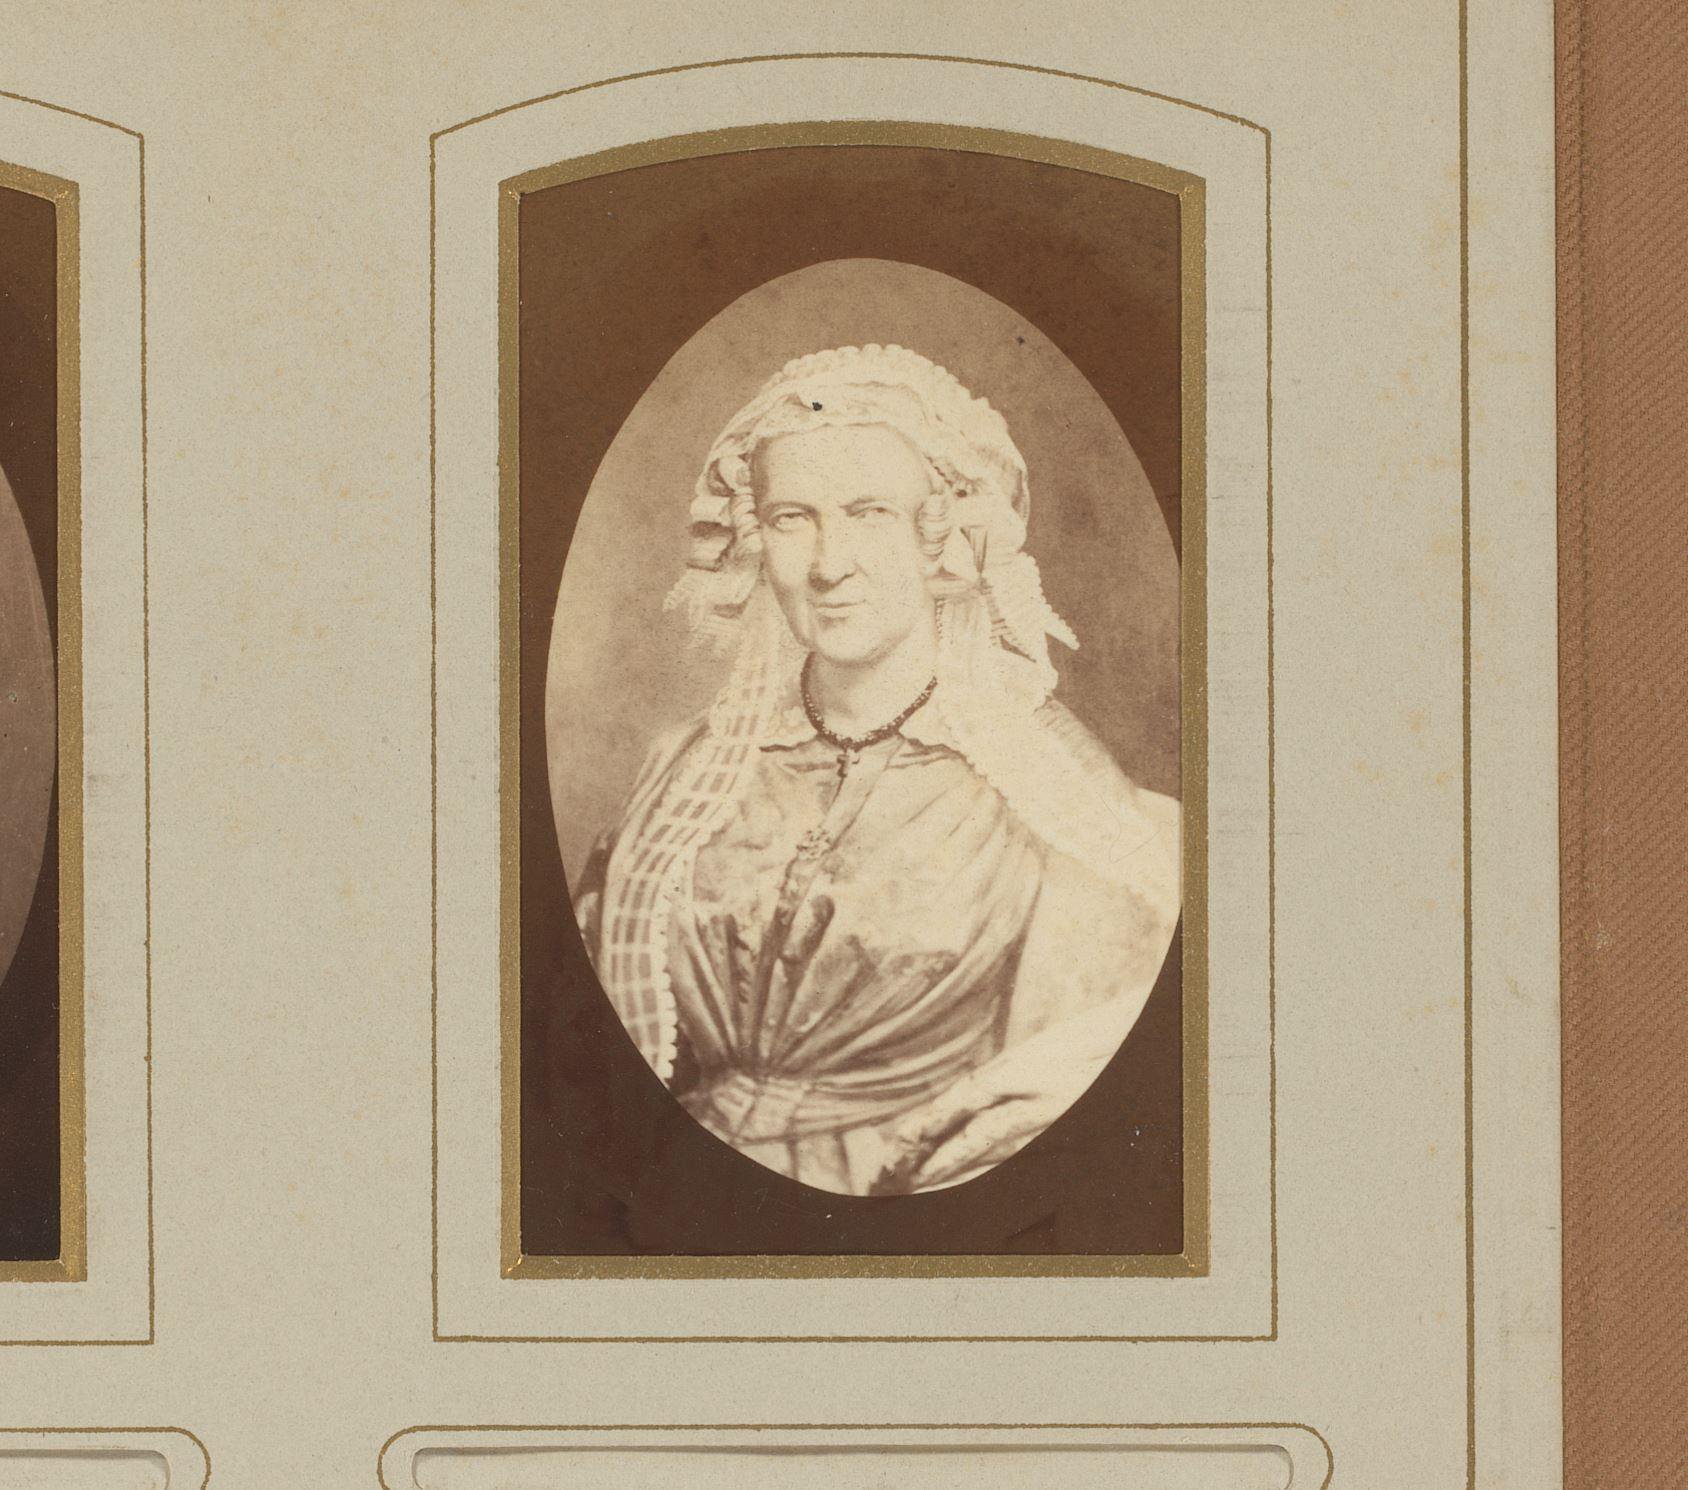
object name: carte de visite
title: Fotoreproductie van een geschilderd portret van een vrouw, aangeduid als oma Ghesquiere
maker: charles emmanuel dhoy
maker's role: fotograaf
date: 1850-1892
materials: cardboard, photographic support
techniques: albumen print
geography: ghent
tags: historical persons - bb - woman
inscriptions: inscription: ‘Charles d'Hoy/ PHOTOGRAPHE/ Rue courte du jour 25 près du Pont Madou/ WALPOORT BRUG/ GAND’, annotation: ‘Bonne Maman/ Ghesquiere/ Magot’